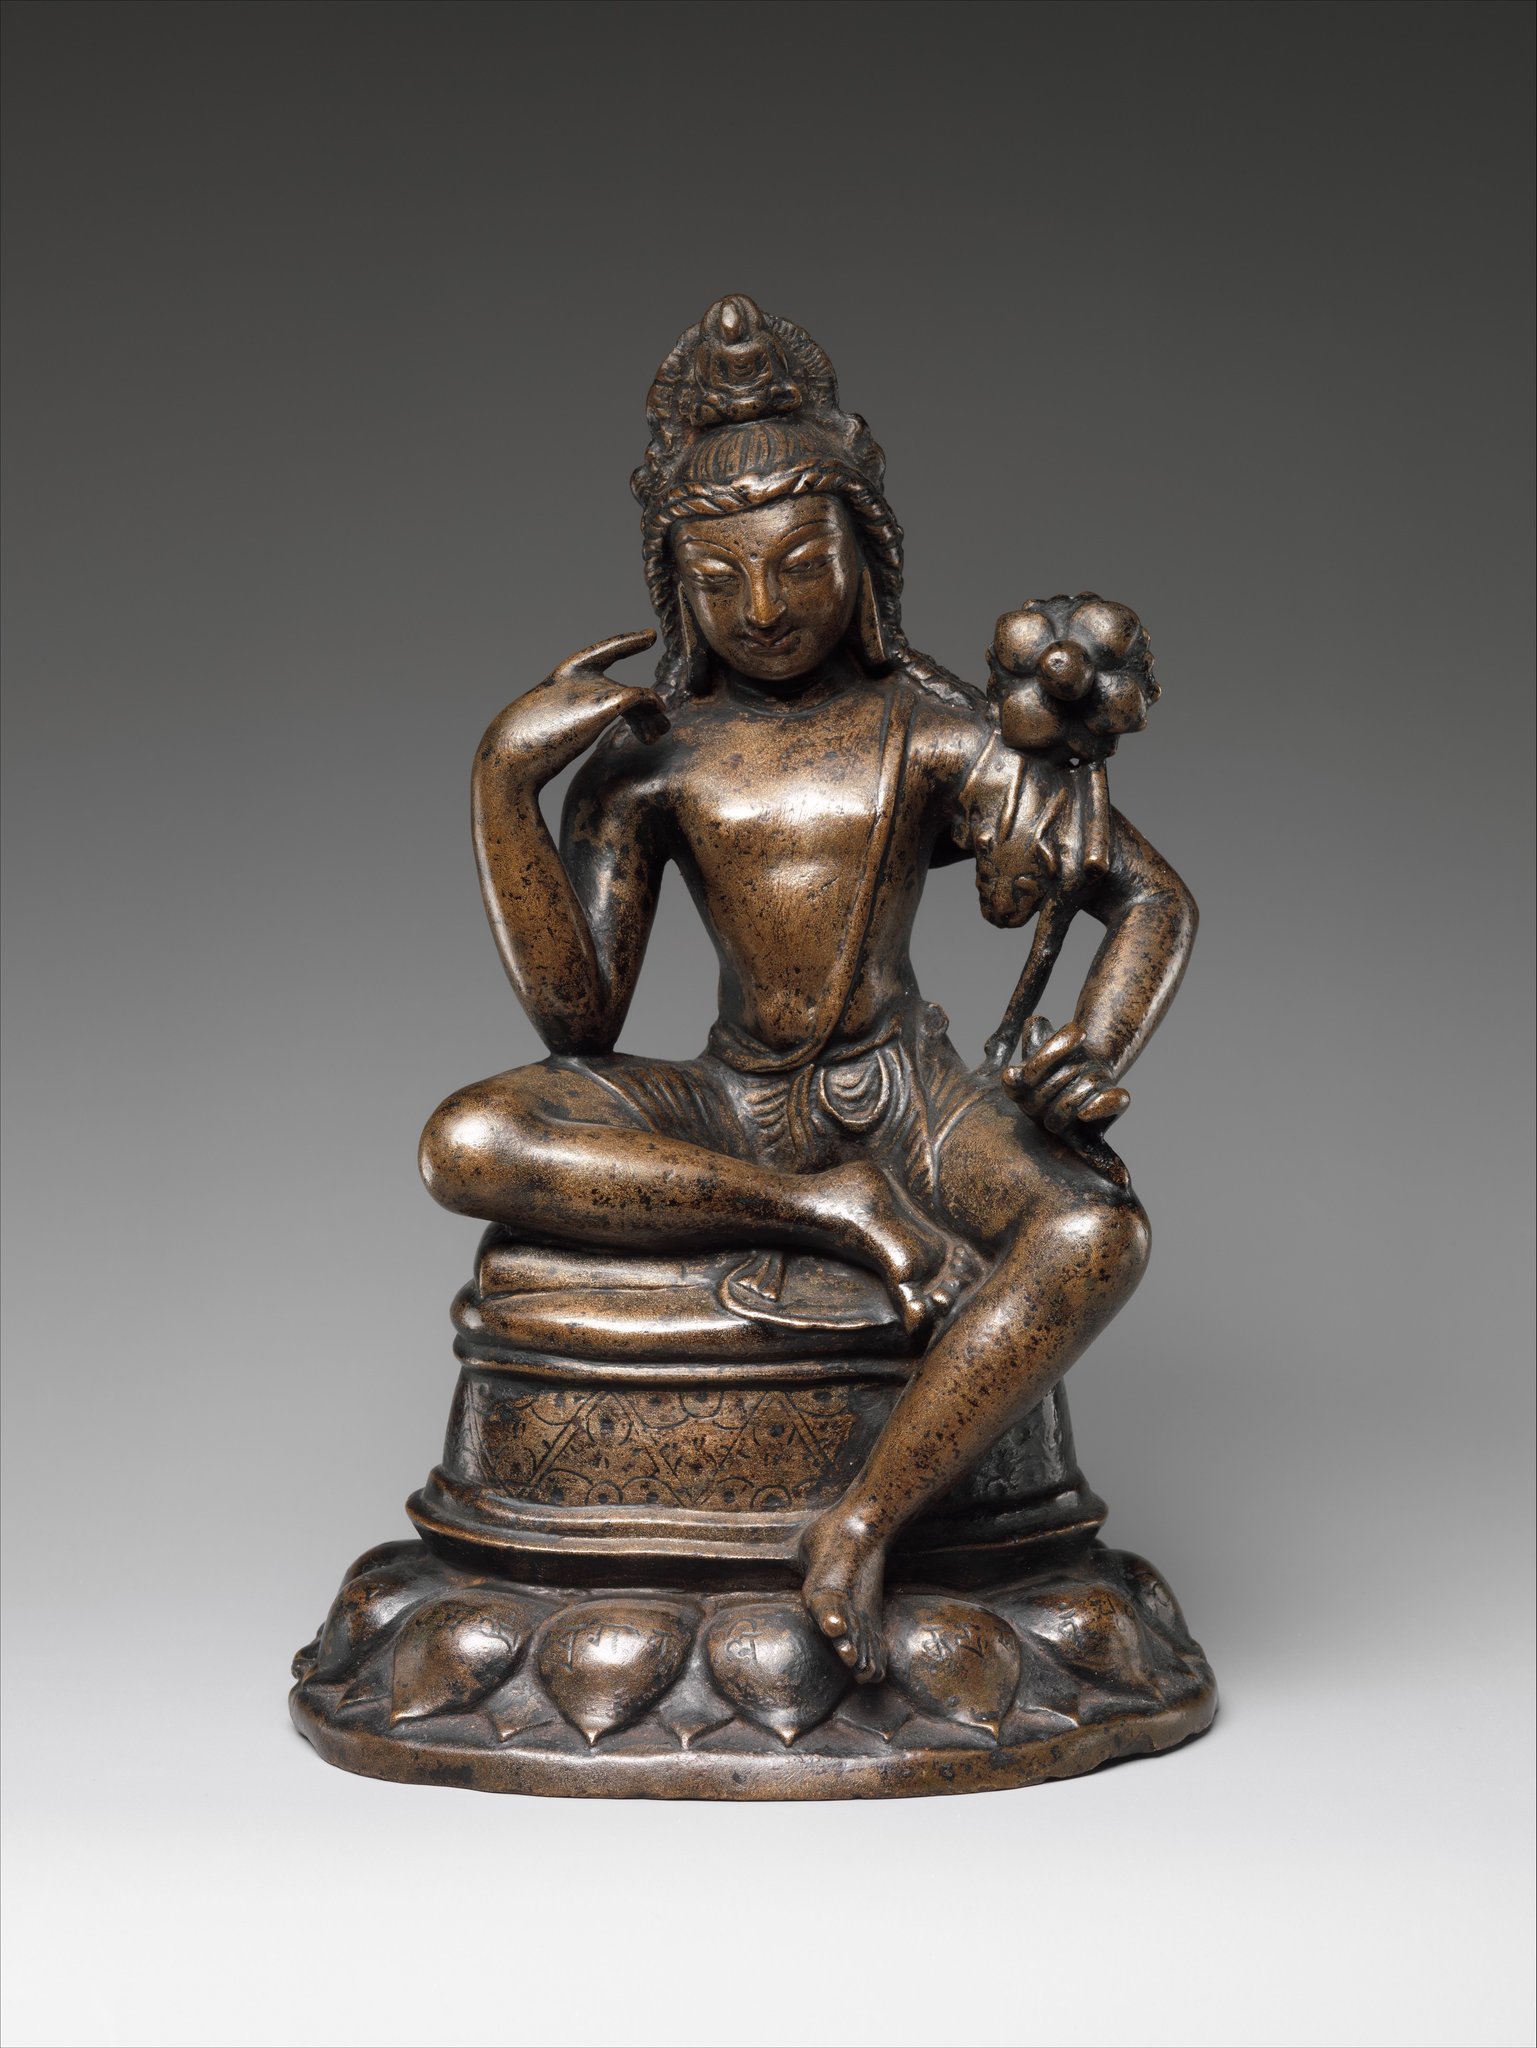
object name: figure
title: Avalokiteshvara Padmapani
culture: pakistani, swat valley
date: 601-700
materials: bronze, copper, silver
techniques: inlay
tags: swat valley,buddhism,avalokiteshvara,bodhisattvas